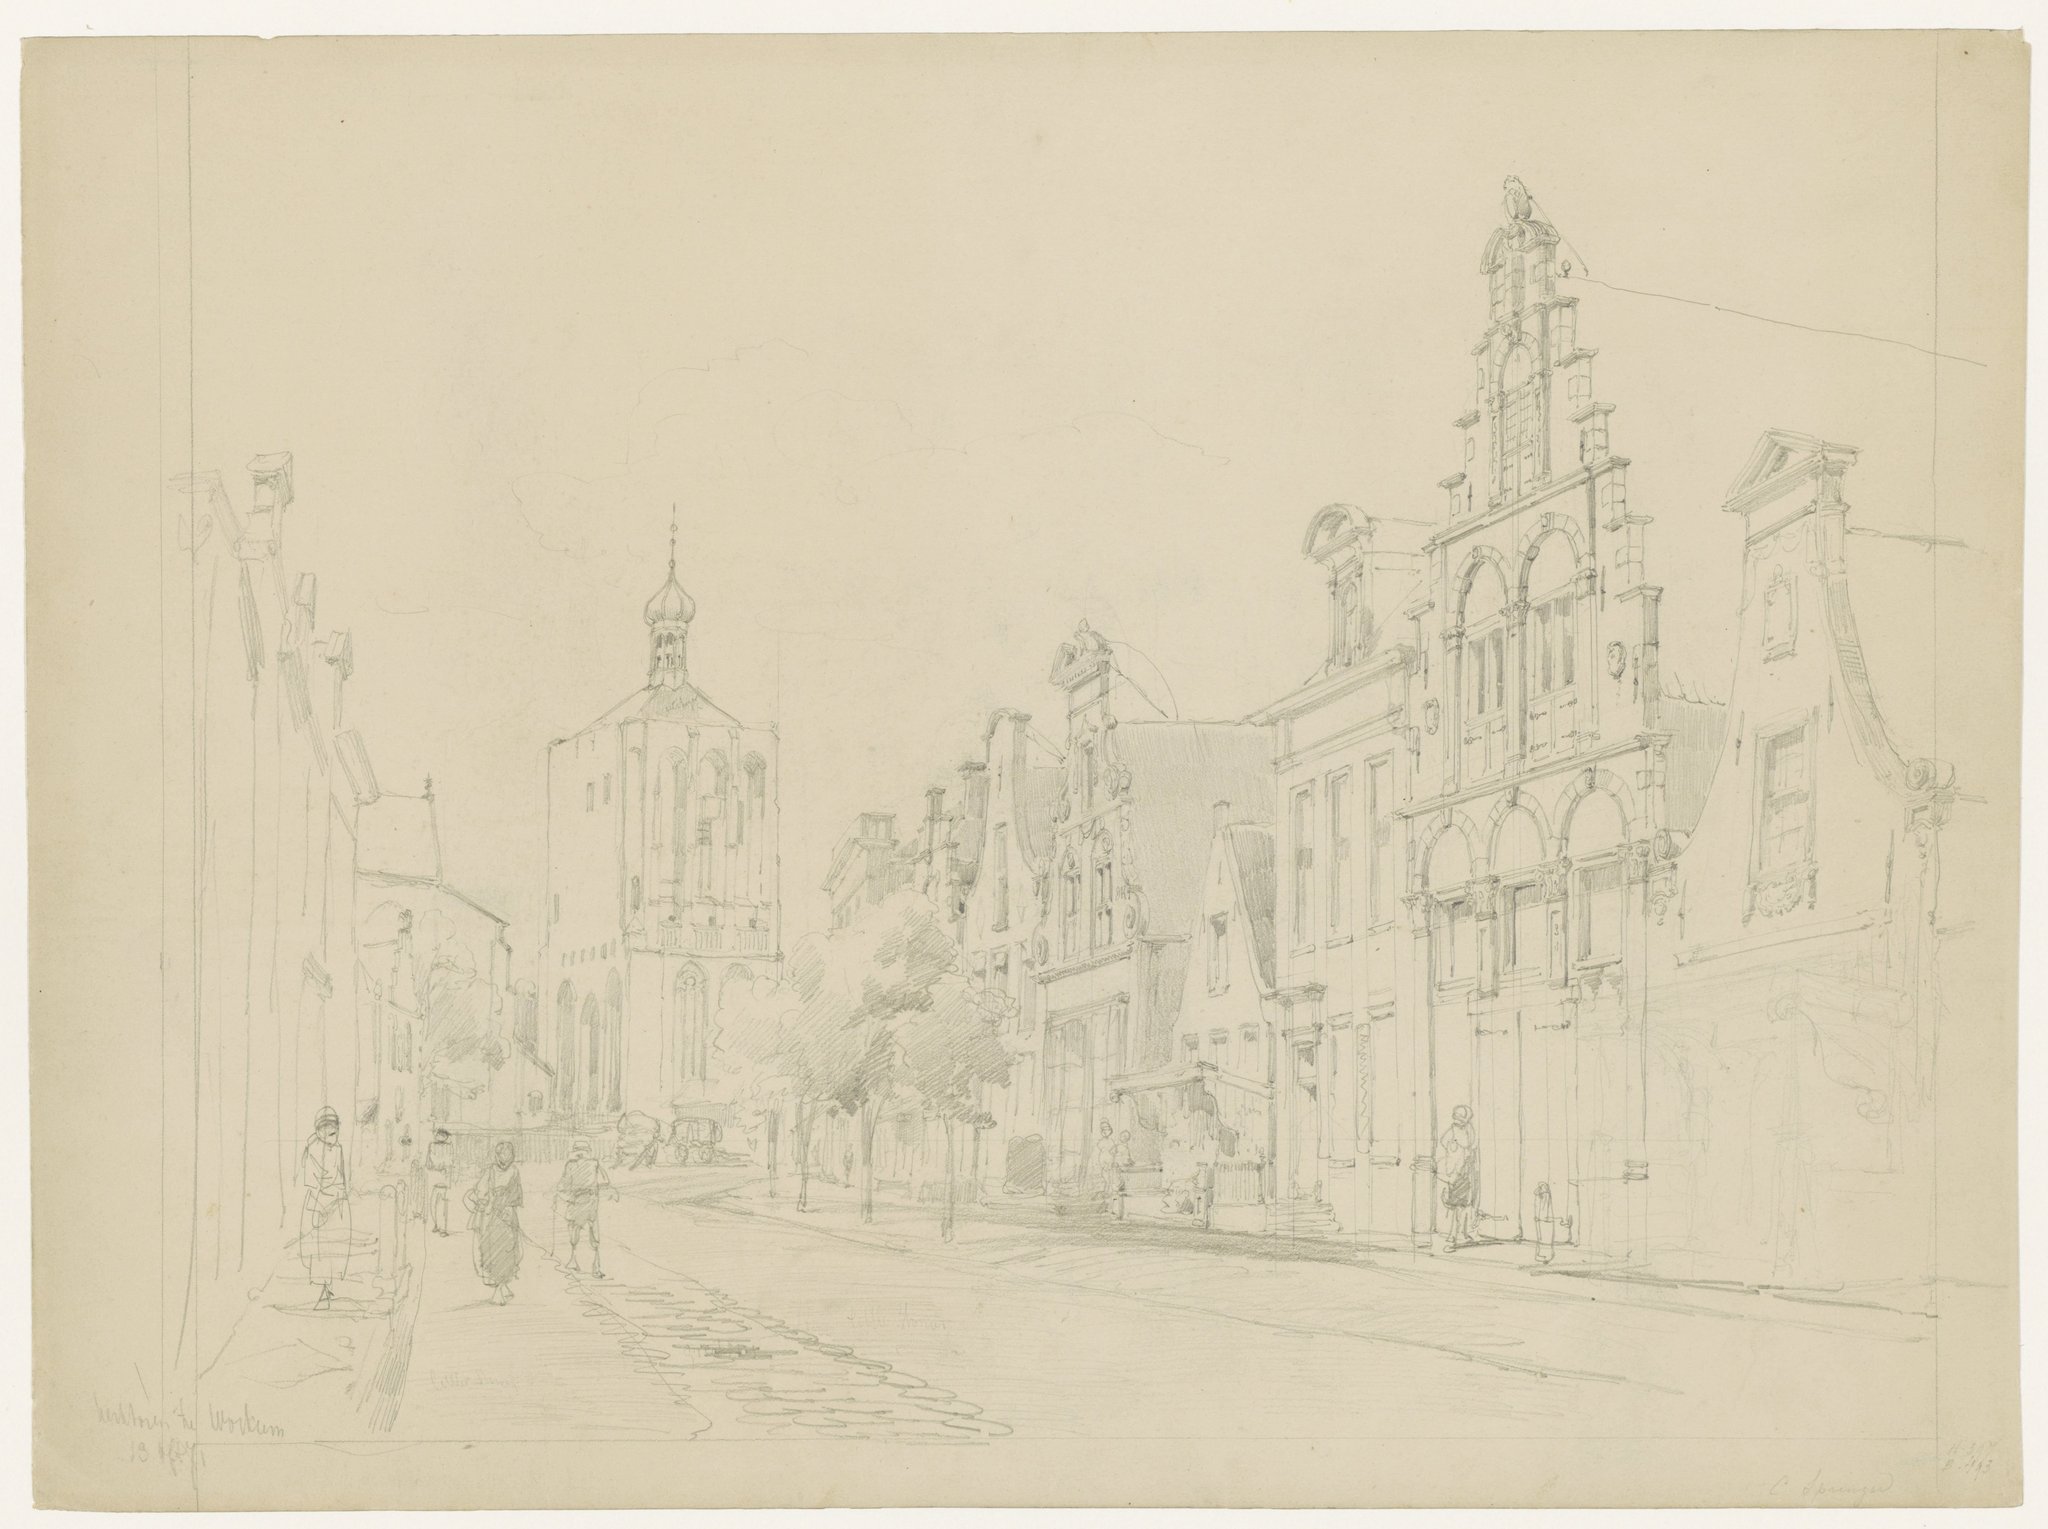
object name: drawing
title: Gezicht te Workum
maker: cornelis springer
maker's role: draughtsman, painter, print maker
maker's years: 1817-1891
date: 1871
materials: paper, pencil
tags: public road